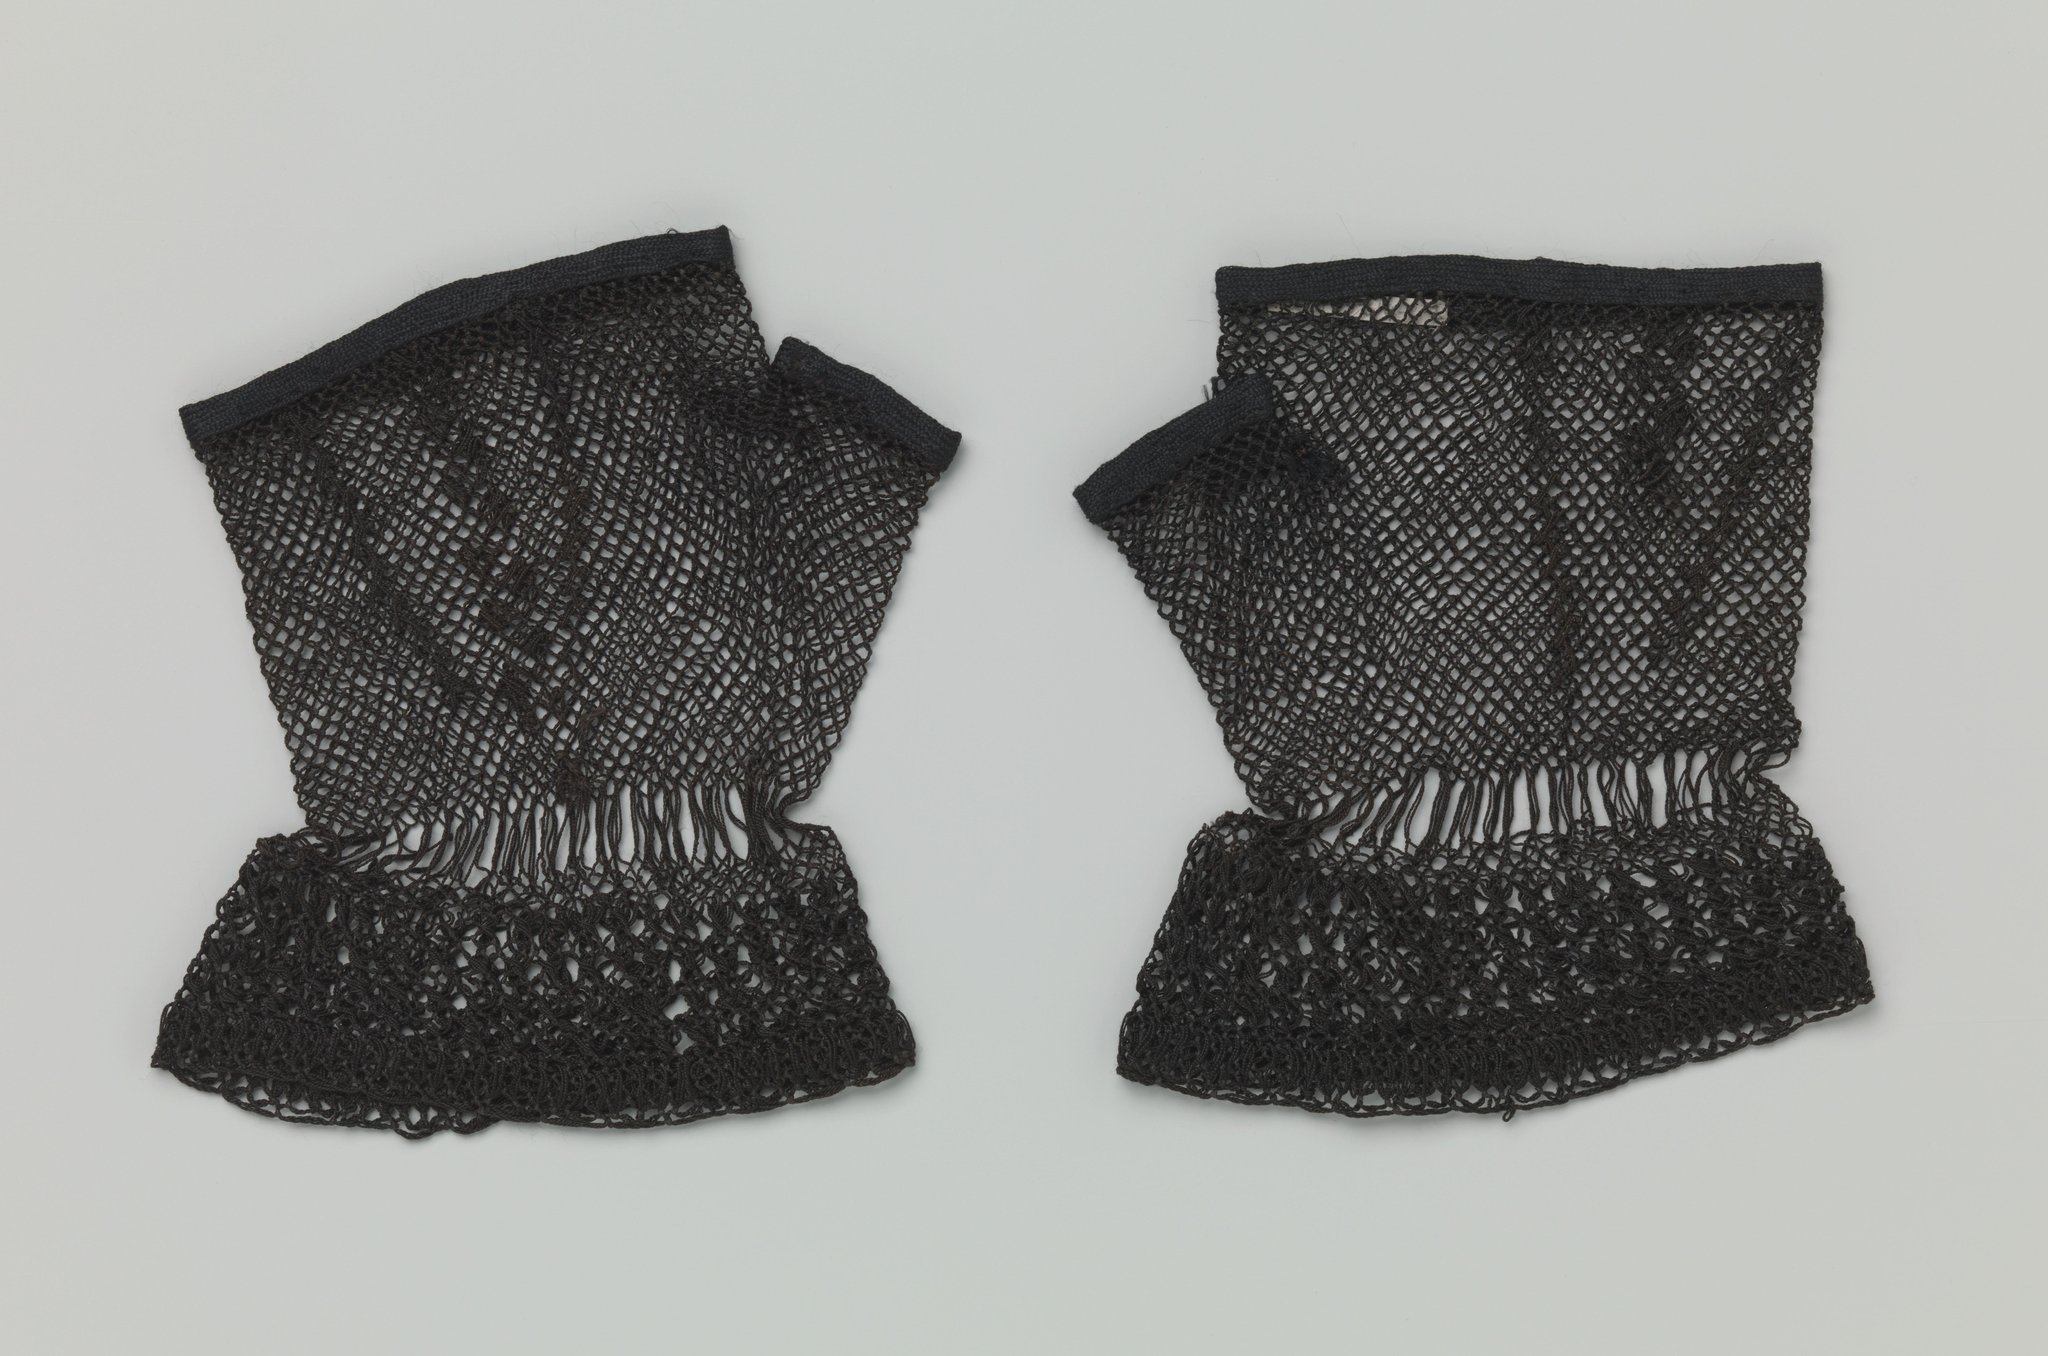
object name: clothing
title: Mitaine van zwarte katoen in Egyptisch vlechtwerk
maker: Anonymous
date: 1900-1925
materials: cotton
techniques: sprang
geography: netherlands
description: Mitaine van zwarte katoen in Egyptisch vlechtwerk.